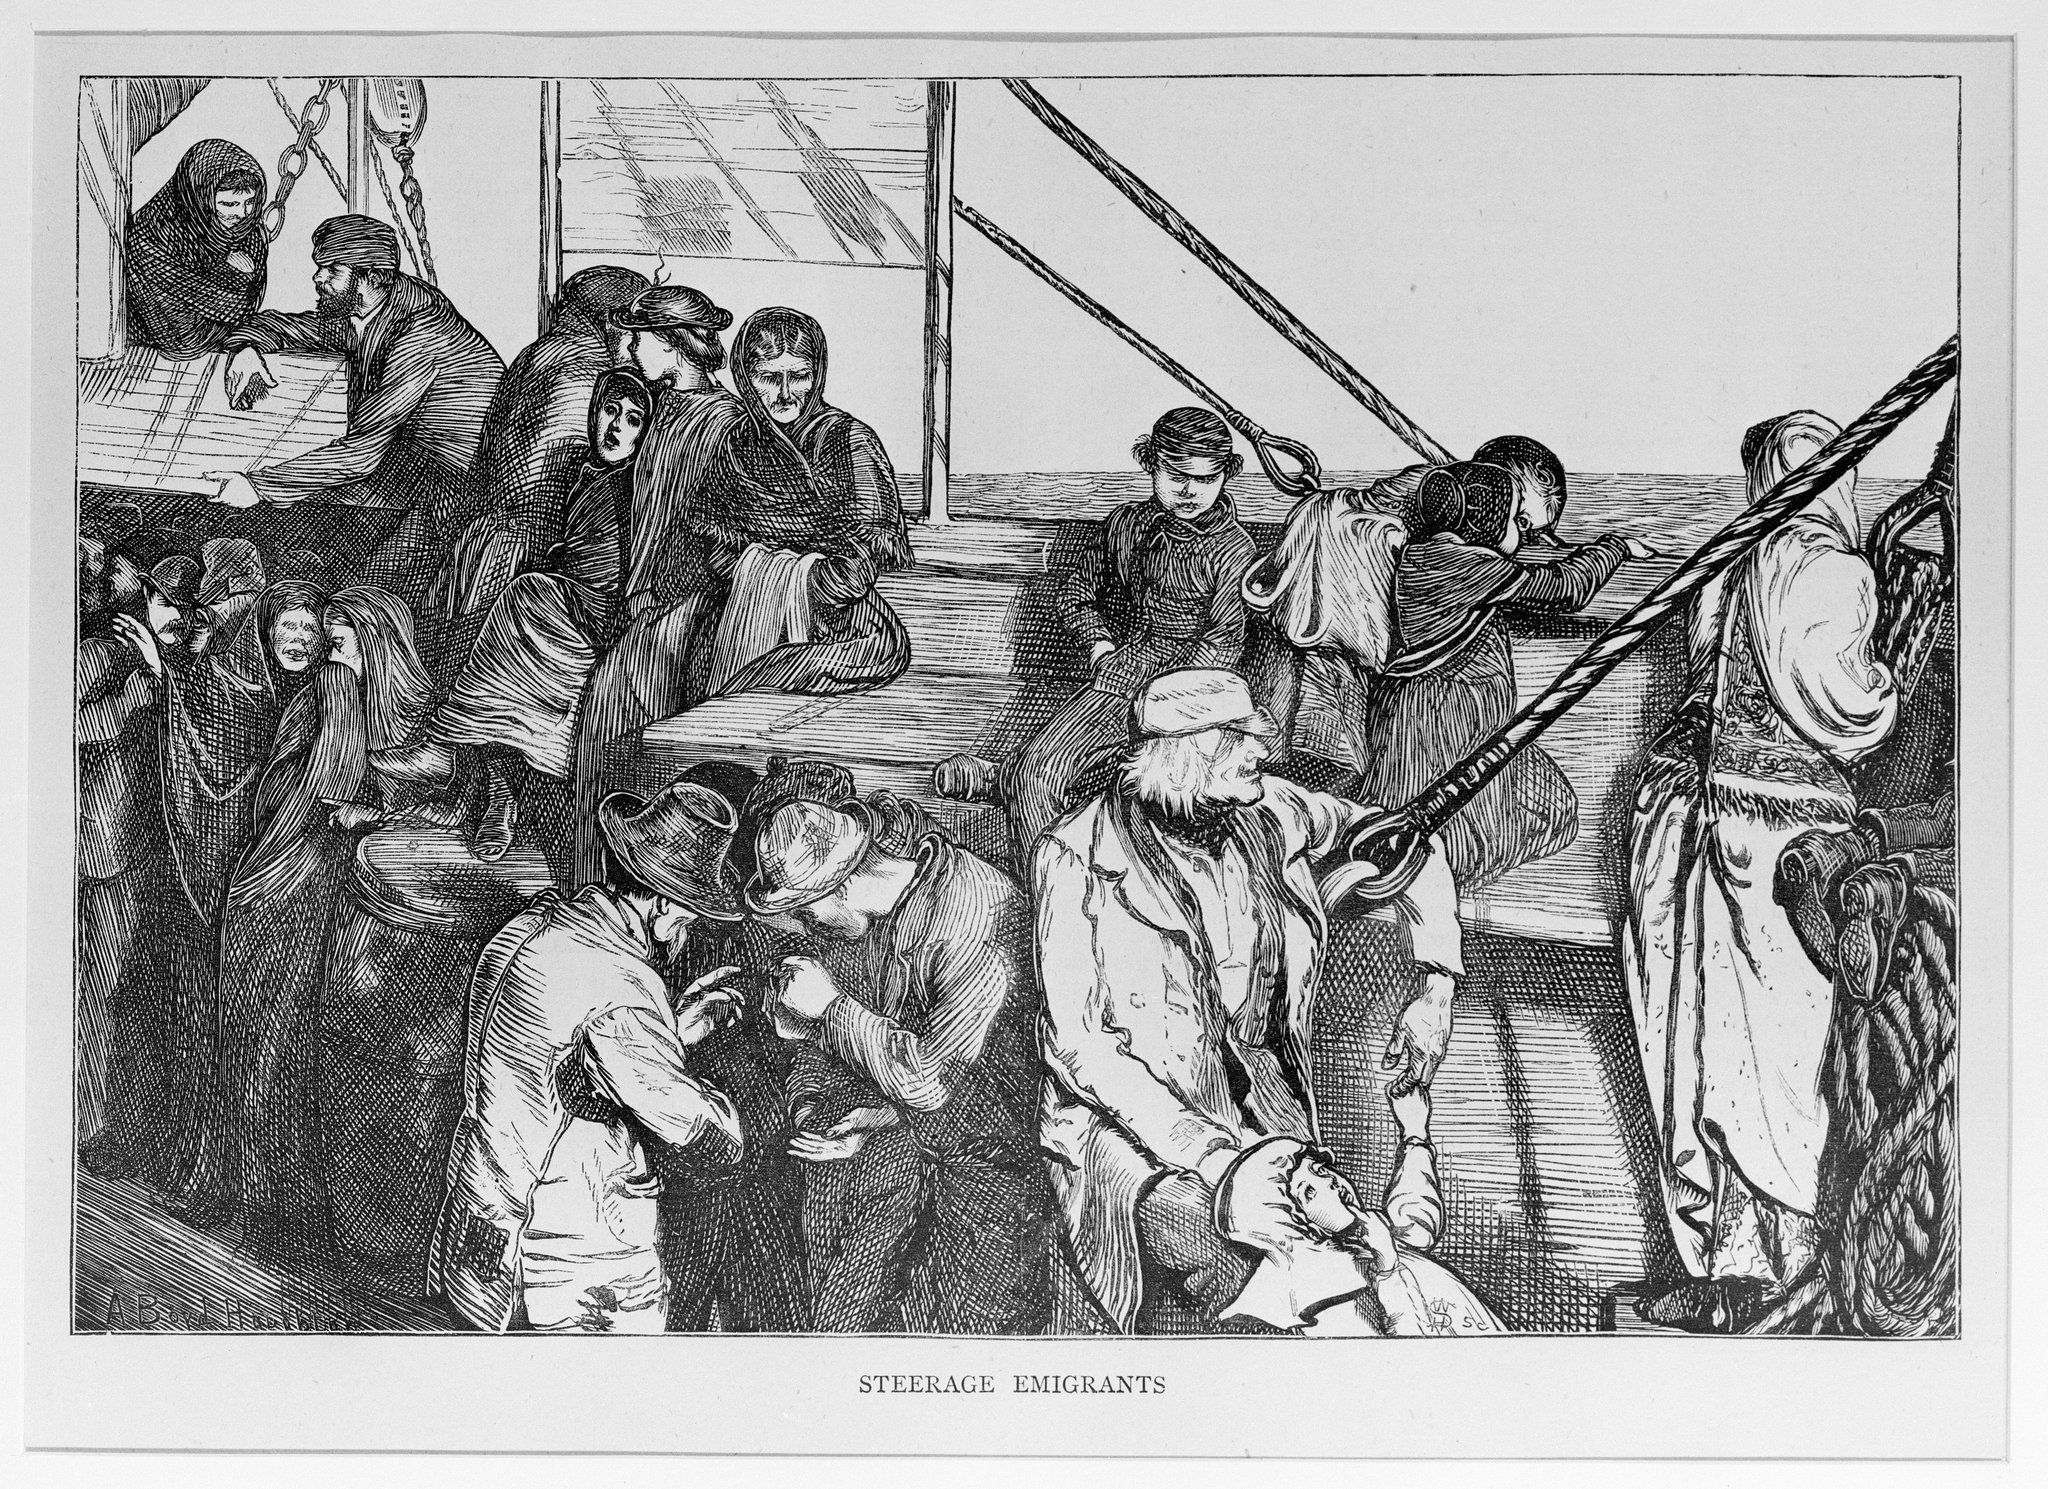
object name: print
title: Steerage Emigrants, from "The Graphic," vol. 1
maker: arthur boyd houghton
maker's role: artist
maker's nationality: british, born india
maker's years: 1836-1875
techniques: engraving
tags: men